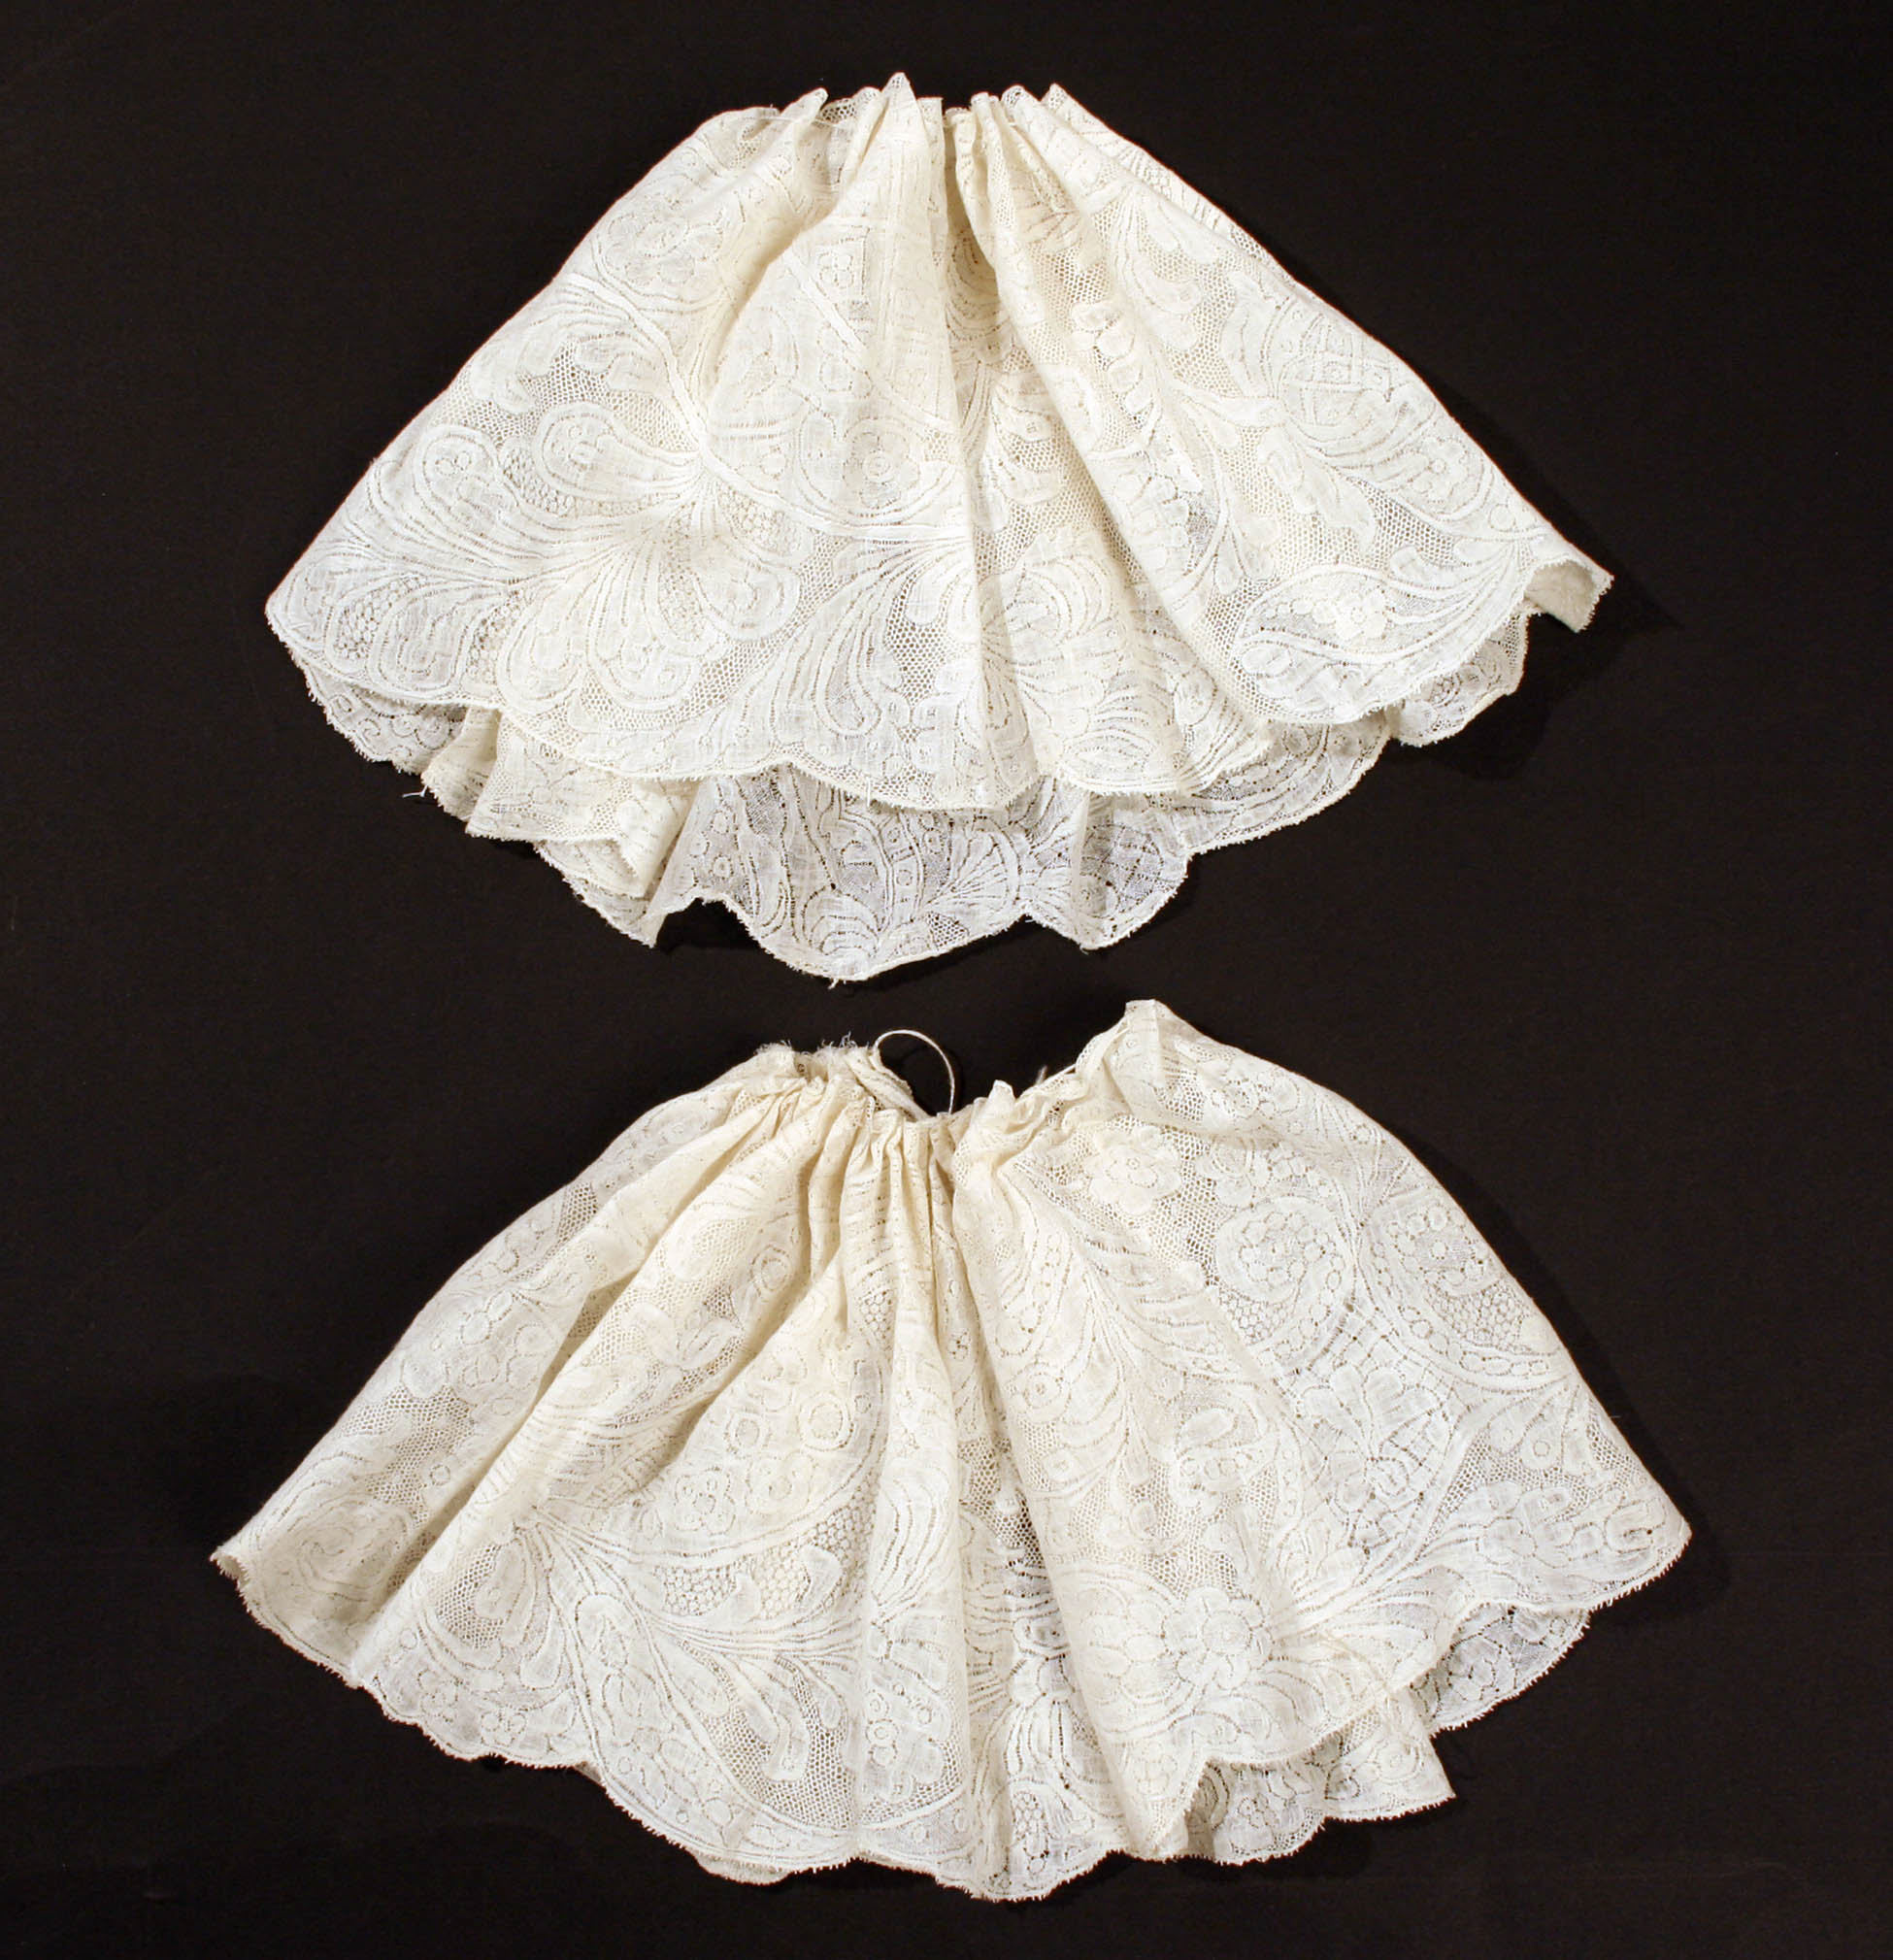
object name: engageantes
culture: european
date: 1701-1733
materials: cotton